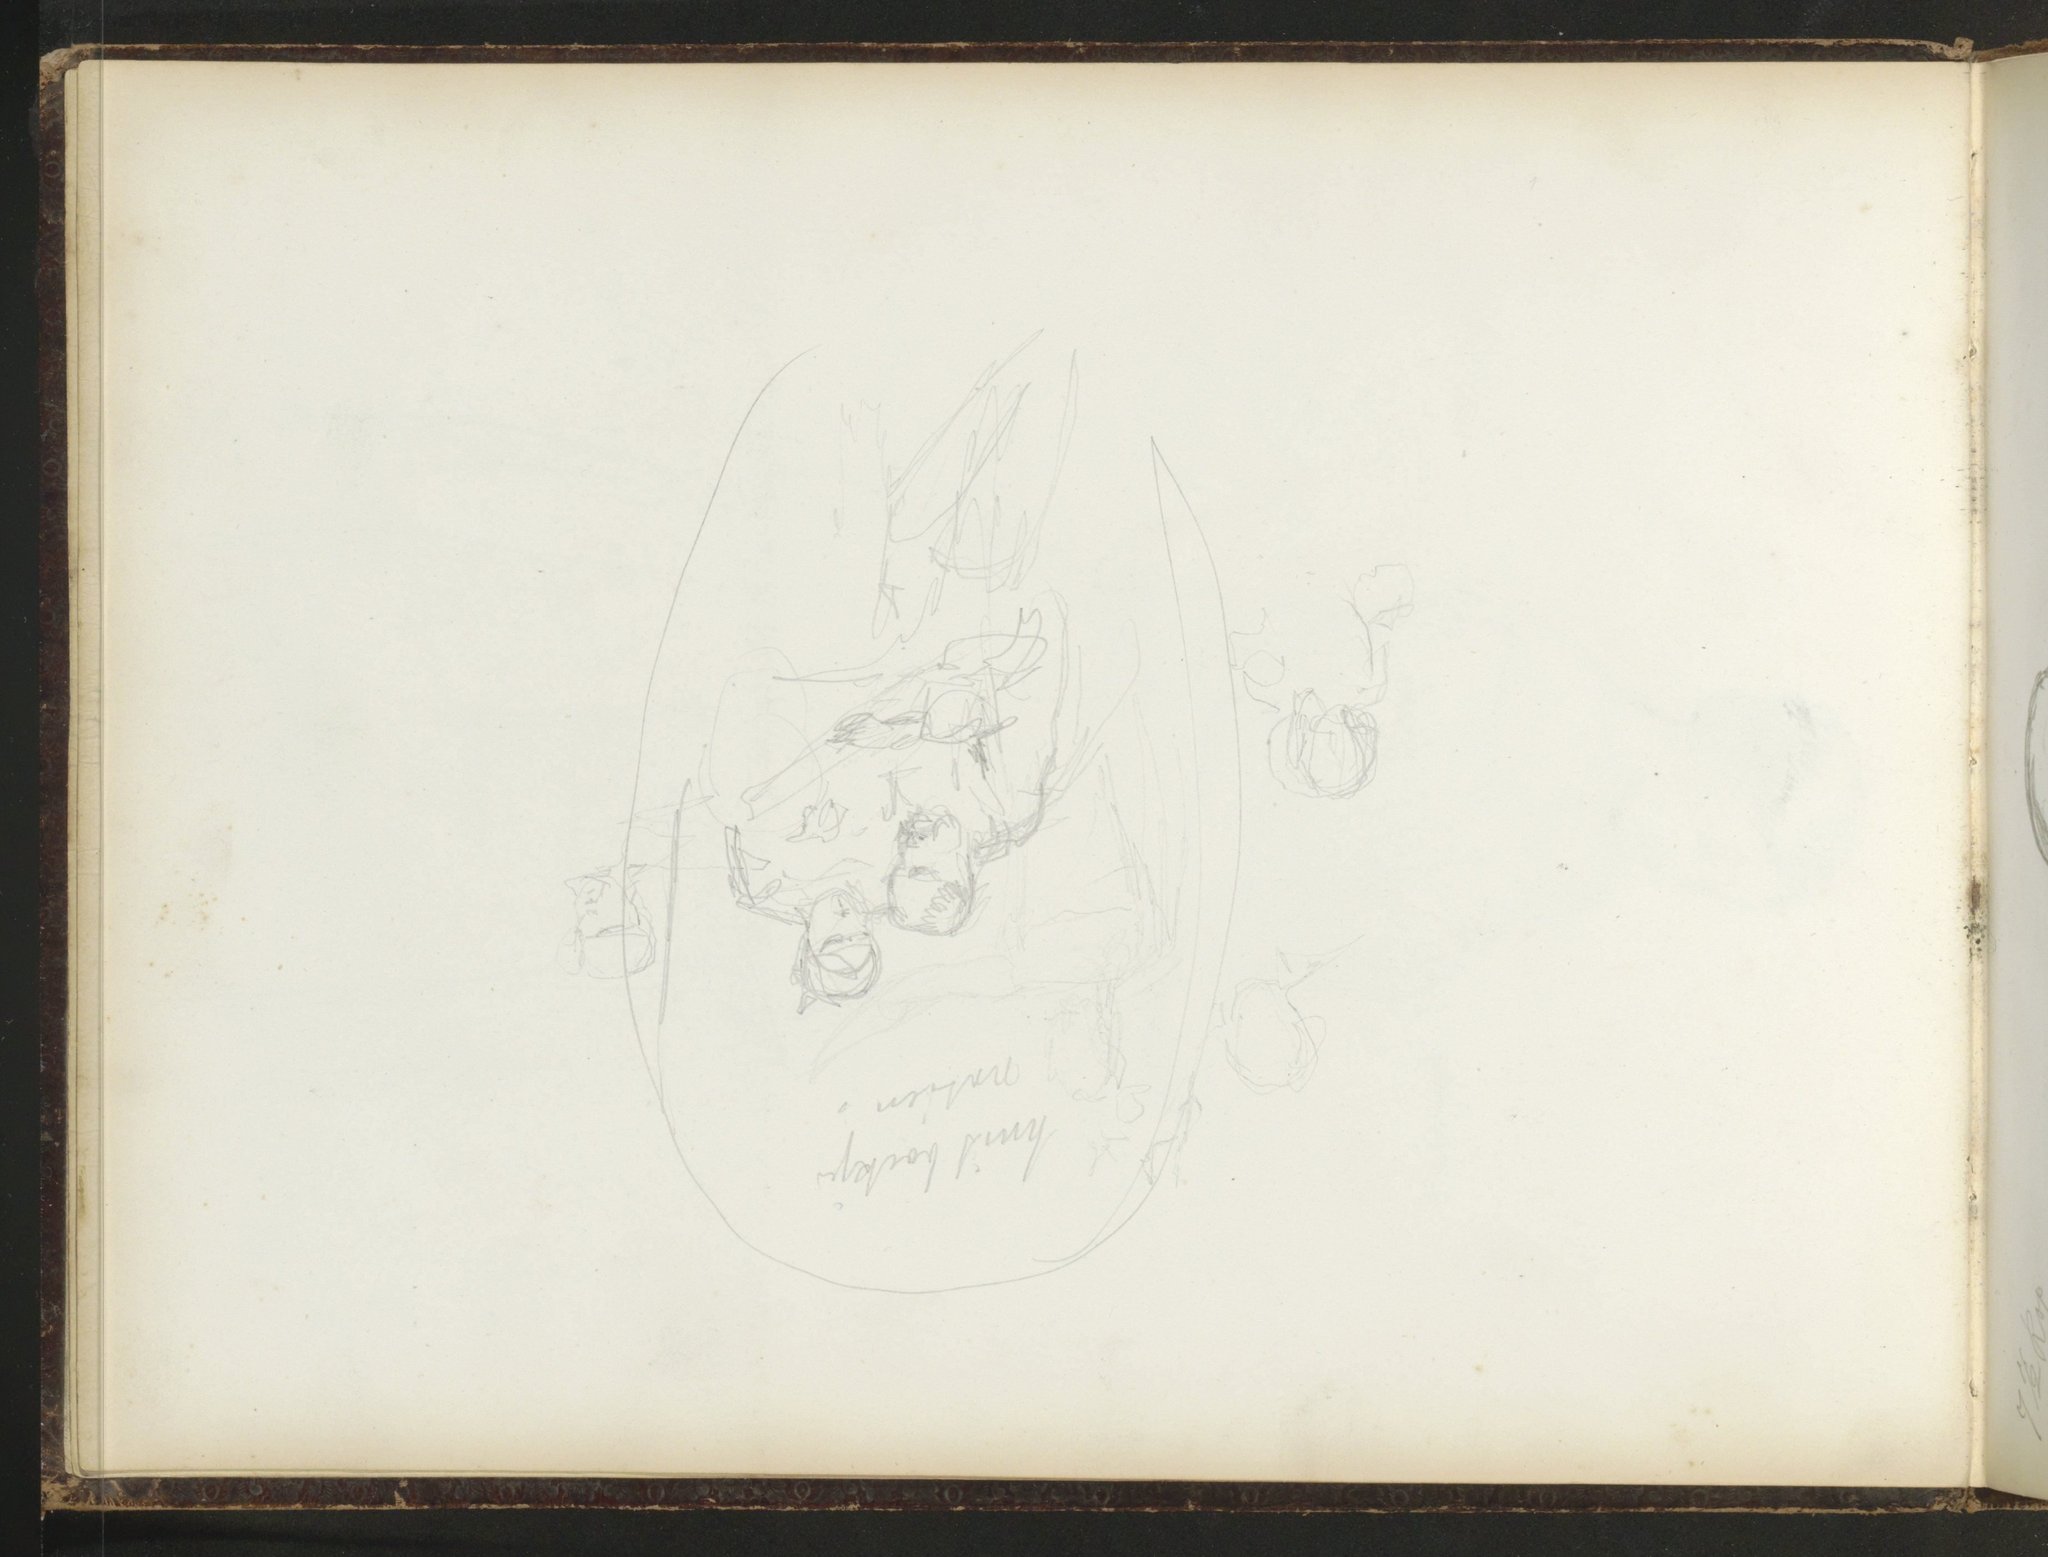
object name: sketchbook leaf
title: Paar dat samen het huishoudboek nakijkt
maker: reinier craeyvanger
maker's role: draughtsman, print maker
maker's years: 1812-1880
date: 1822-1880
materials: paper, pencil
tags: head (human), reading, (lovers) embracing each other, 'symplegma'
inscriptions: annotation: ‘huis boekje/ nazien’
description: De man houdt het boek in de hand. Tevens studies van koppen en een figuur met uitgestrekte arm. Blad 3 verso uit een schetsboek met 45 bladen.